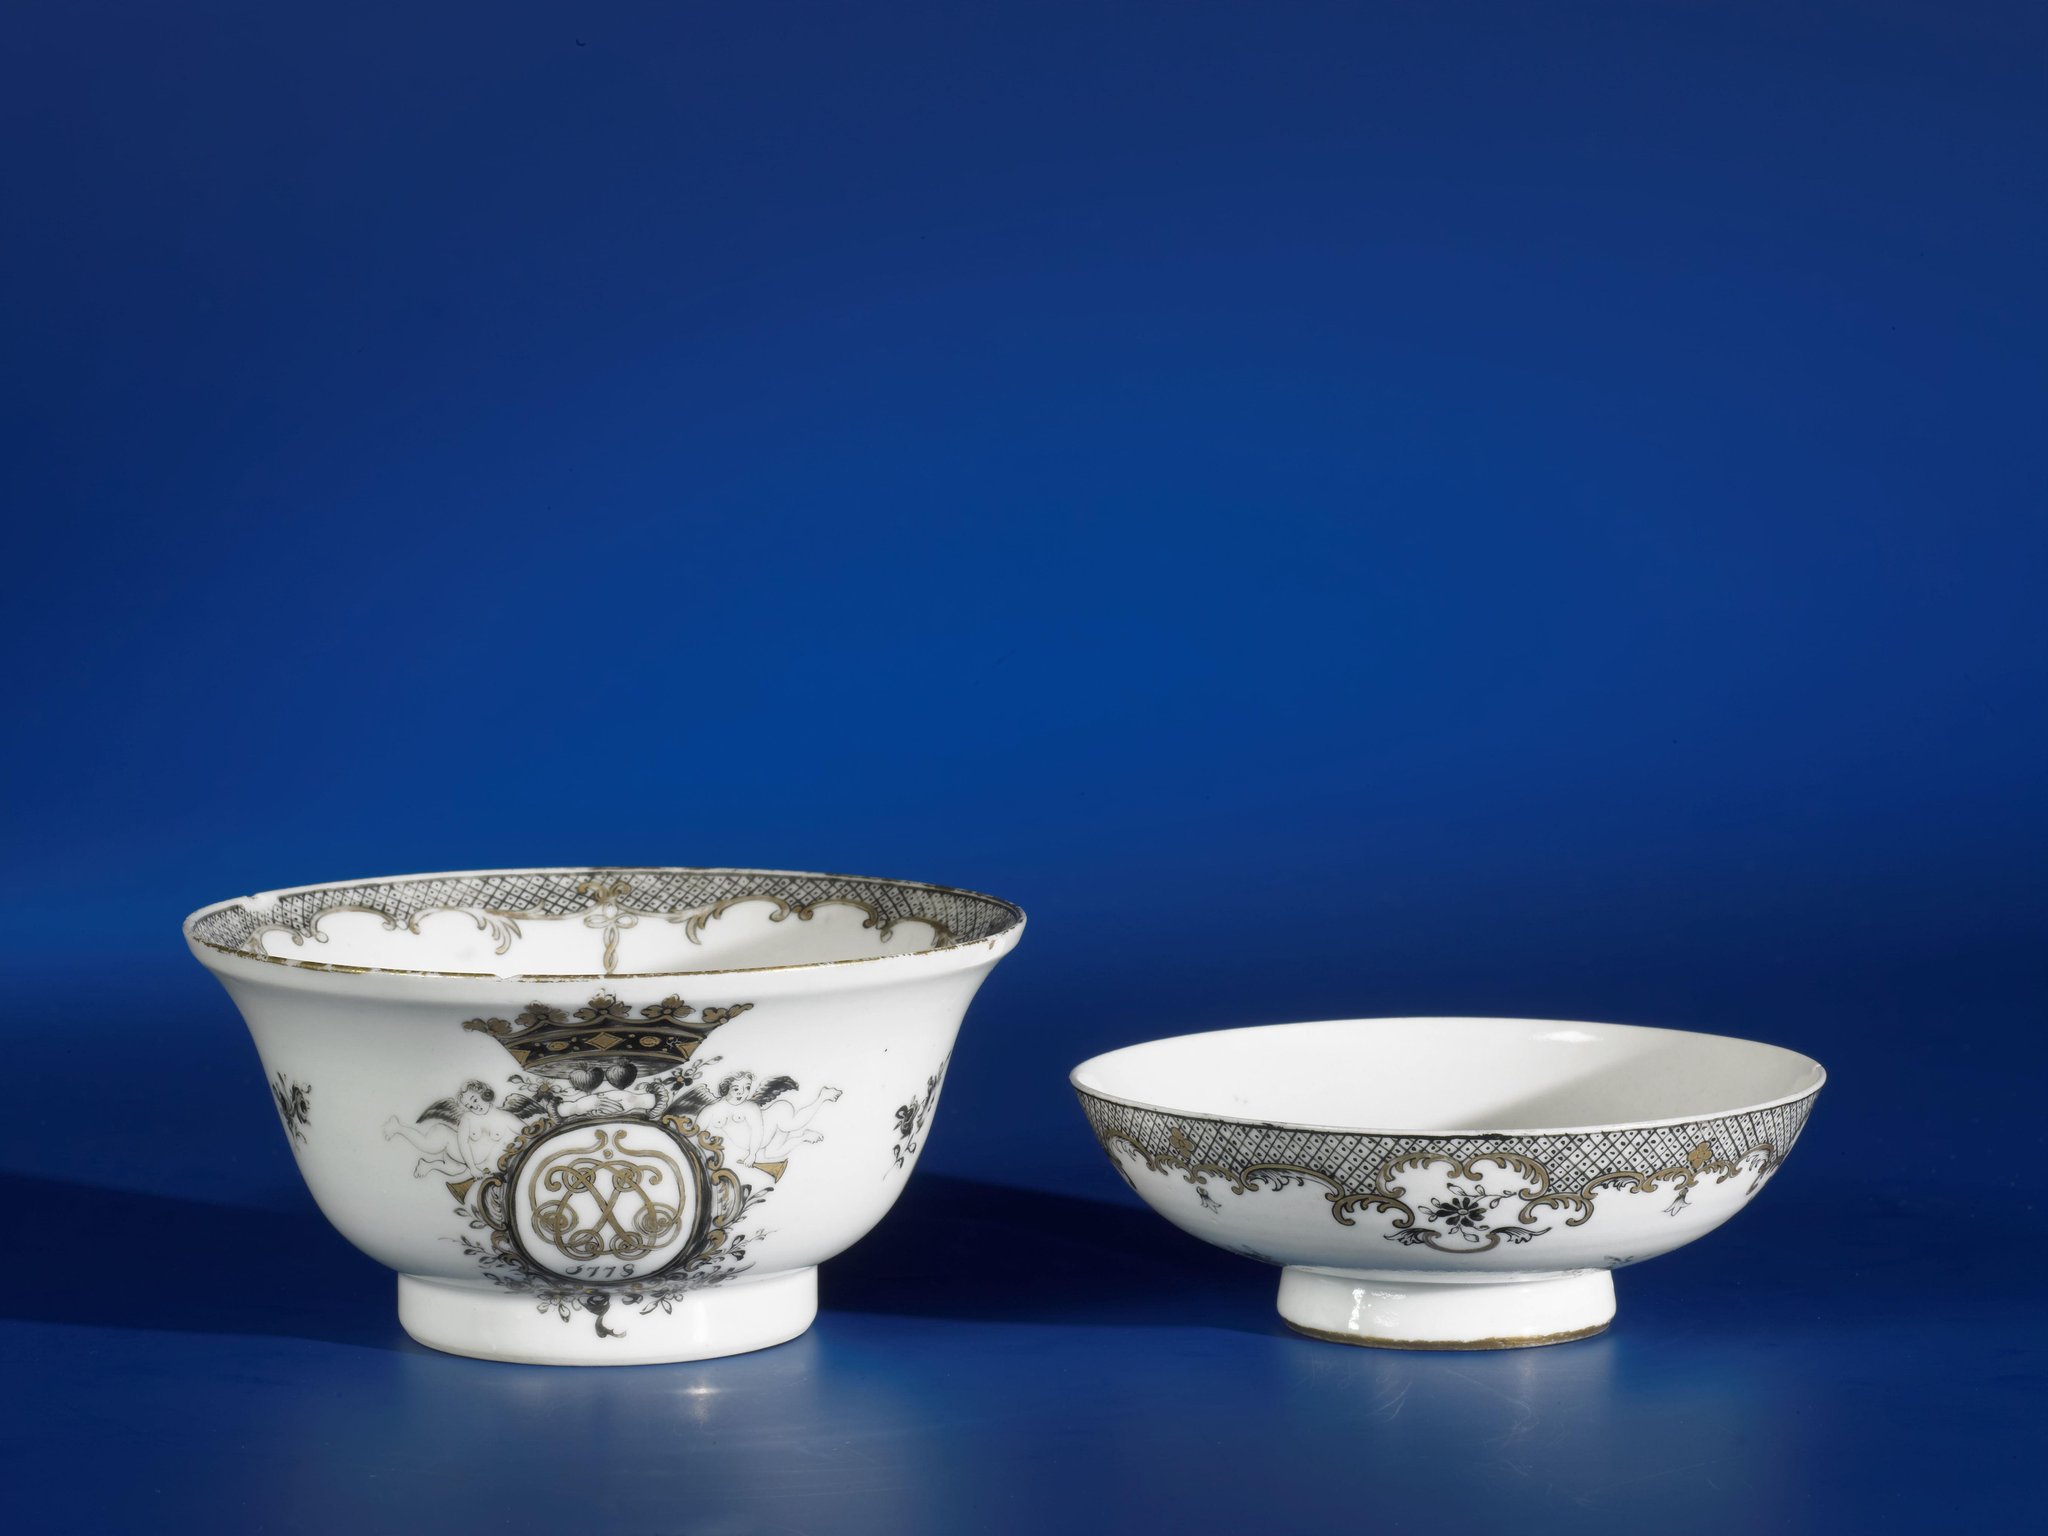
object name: covered bowl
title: Covered bell-shaped bowl with a monogram in a richly adorned panel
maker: Anonymous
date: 1778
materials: glaze, gold, paint, porcelain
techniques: firing, gilding, turning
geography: china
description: Wijd uitlopende kom op een voetring, met deksel. Op het deksel een ringknop. Gedecoreerd in encre de Chine en goud. Op de kom een monogram met de initialen EL en CS, gedateerd 1778. Aan beide zijden van het monogram een engel, boven het monogram een kroon. Aan de binnenzijde van de kom een rand van servetwerk. Een zelfde rand op de deksel.